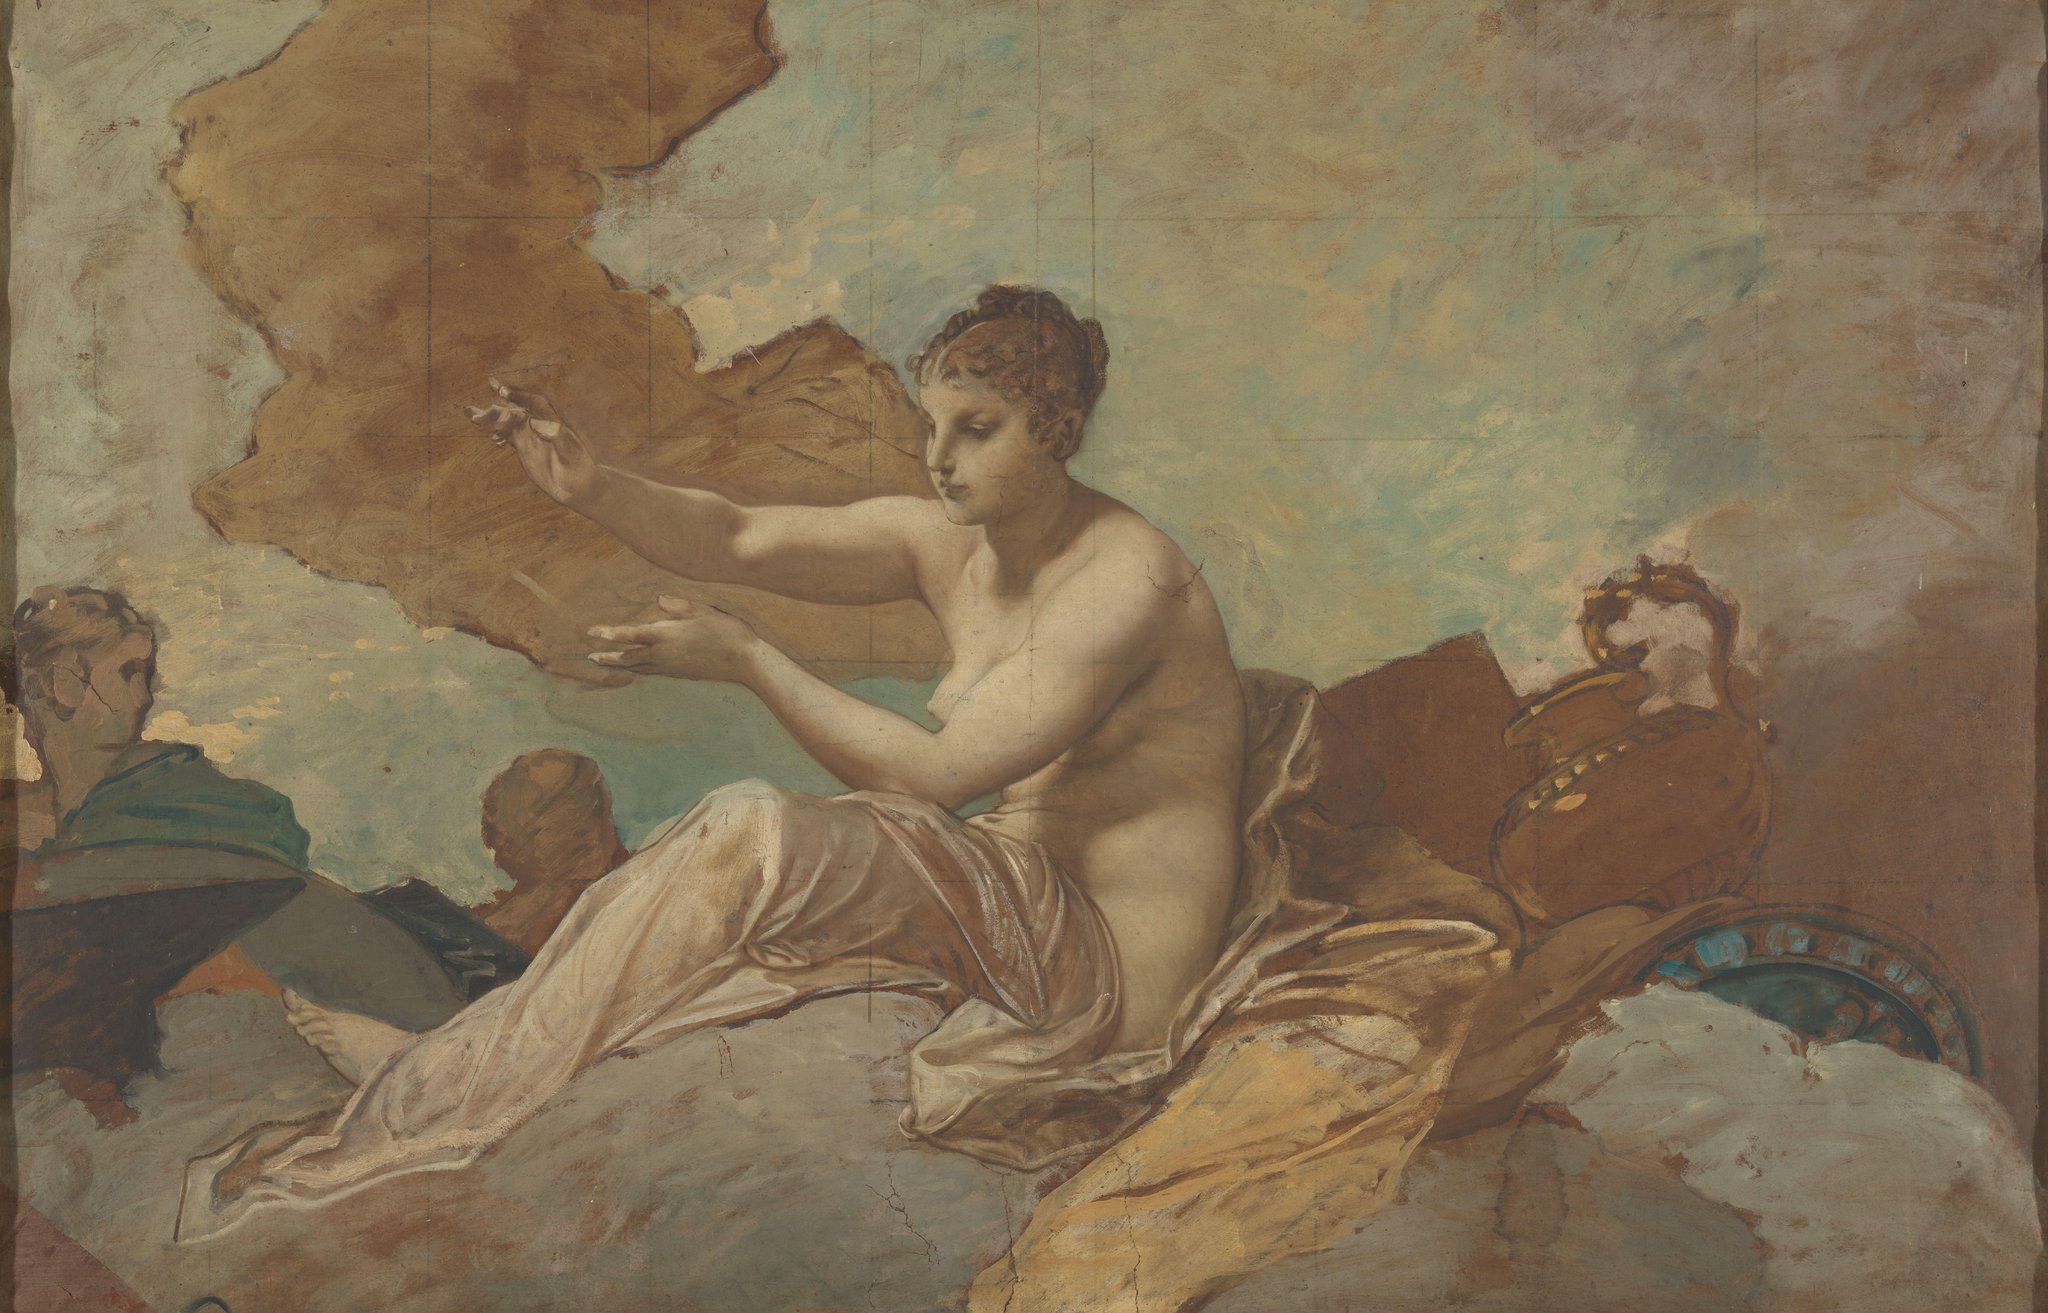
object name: painting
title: Industry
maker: pierre victor galland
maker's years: 1822-1892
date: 1845-1892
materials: canvas, oil, paper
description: De Industrie. Schets van de naakte vrouwelijke personificatie van de Industrie, gezeten op de wolken, naast haar producten van ceramiek.